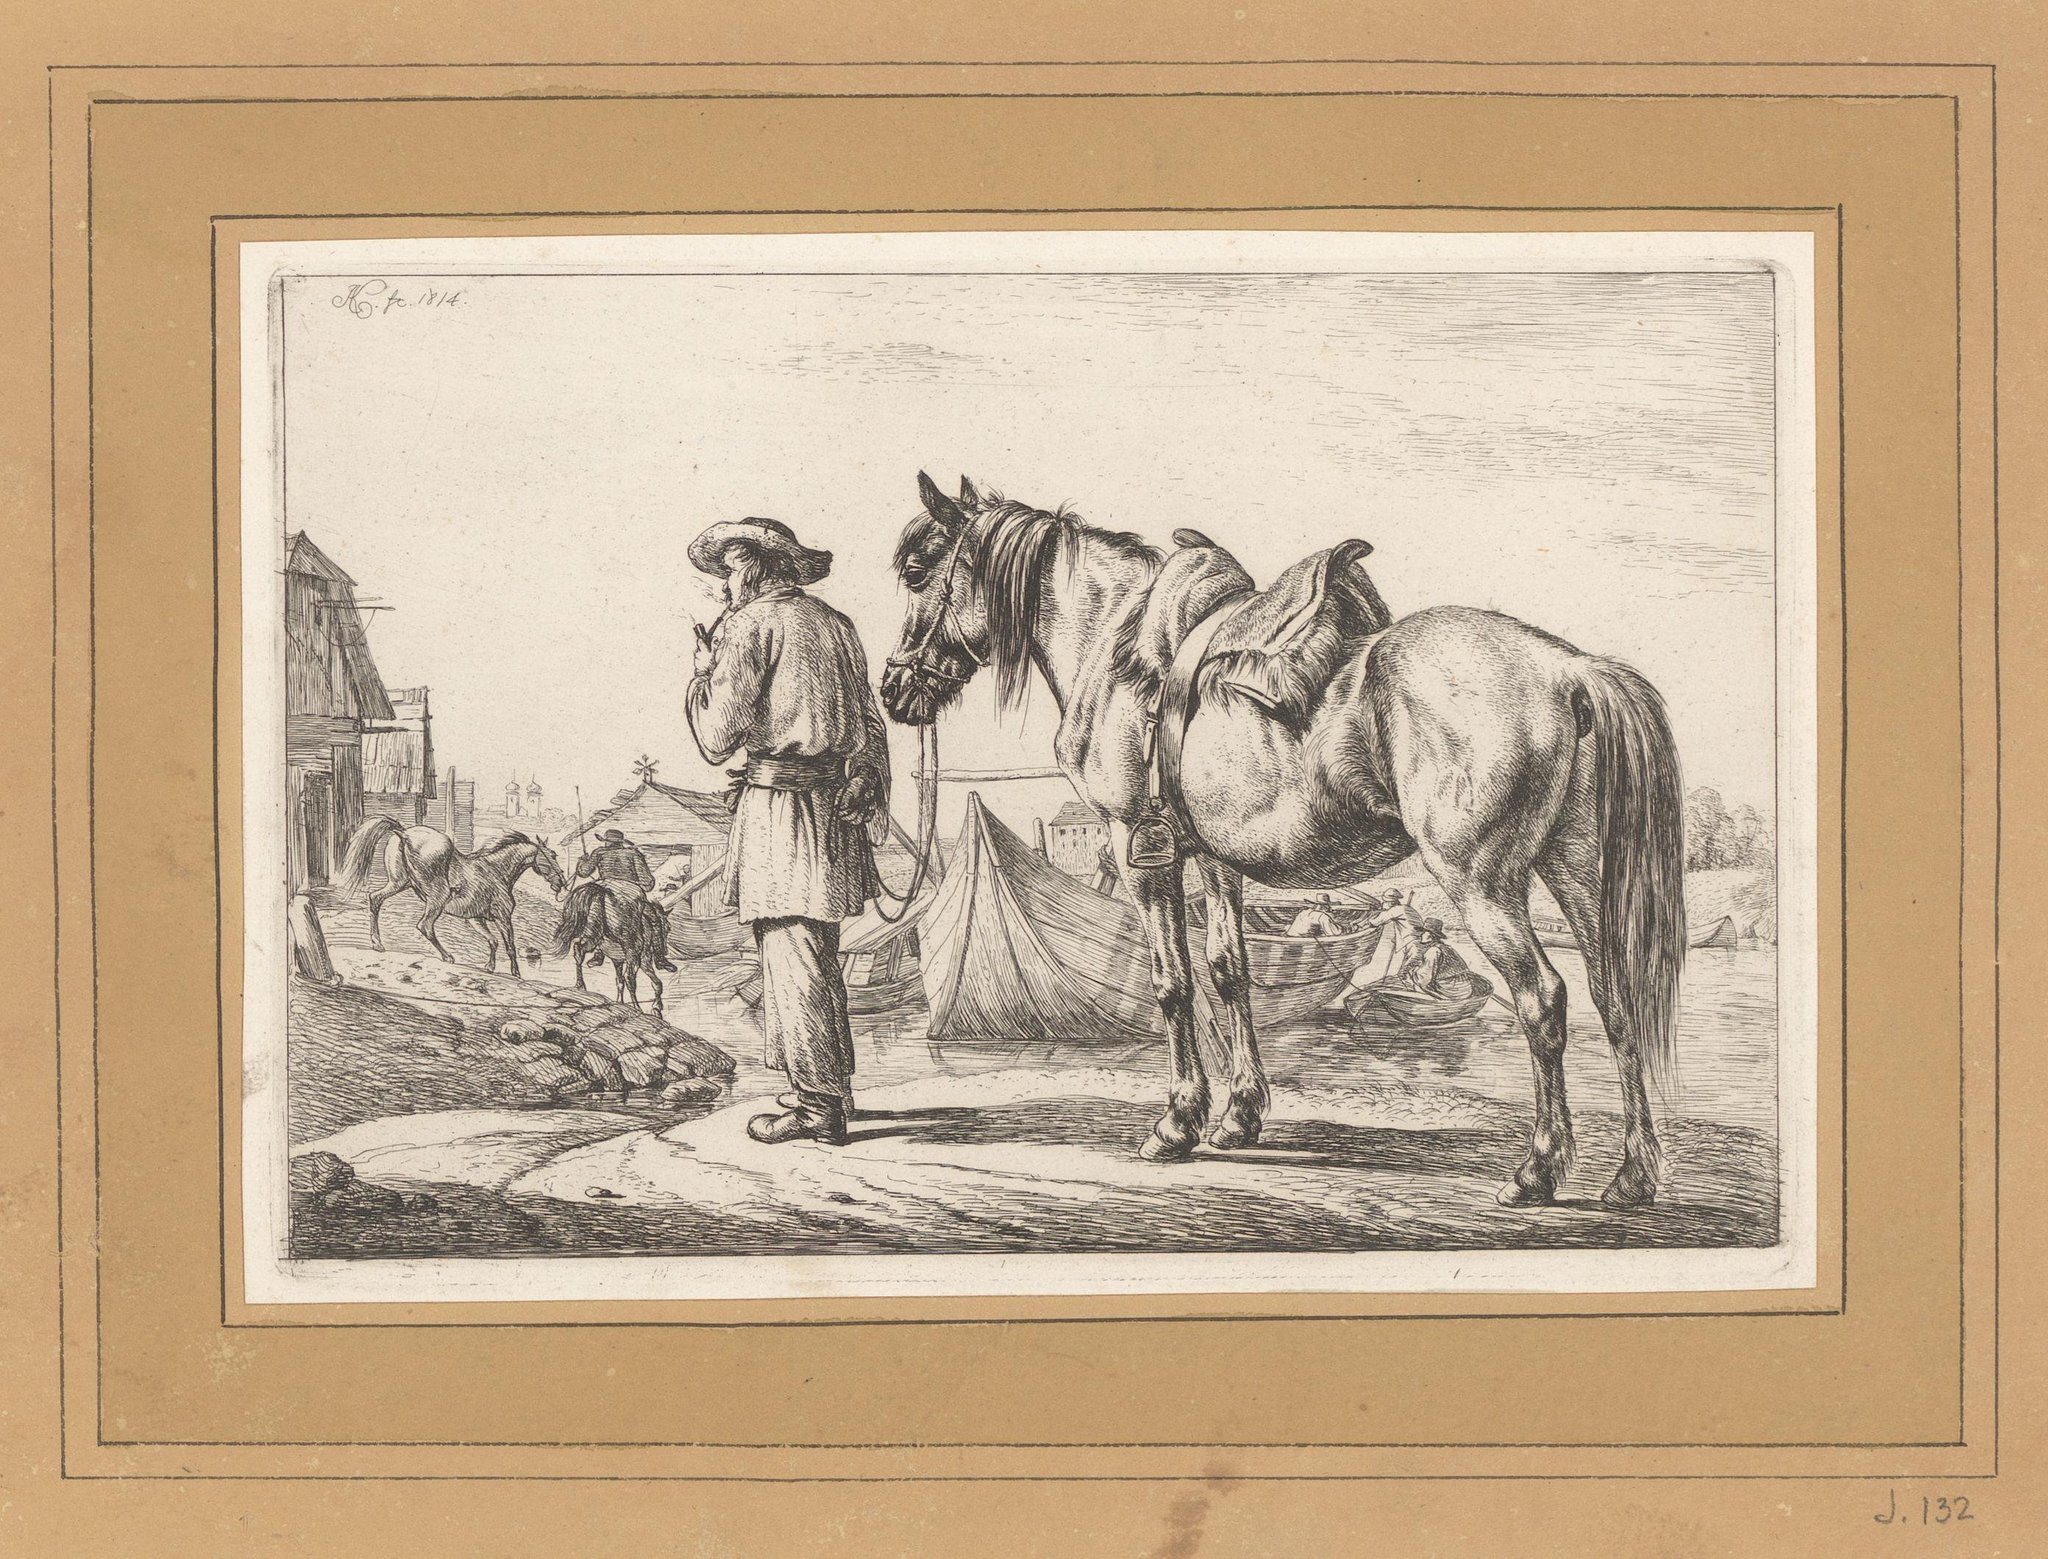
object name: print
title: Boeren met paarden bij een oever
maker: johann adam klein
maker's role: draughtsman, print maker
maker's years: 1792-1875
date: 1814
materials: paper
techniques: etching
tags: river bank, farmers, horse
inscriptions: collector's mark: Lugt 2228, collector's mark: Lugt 2760